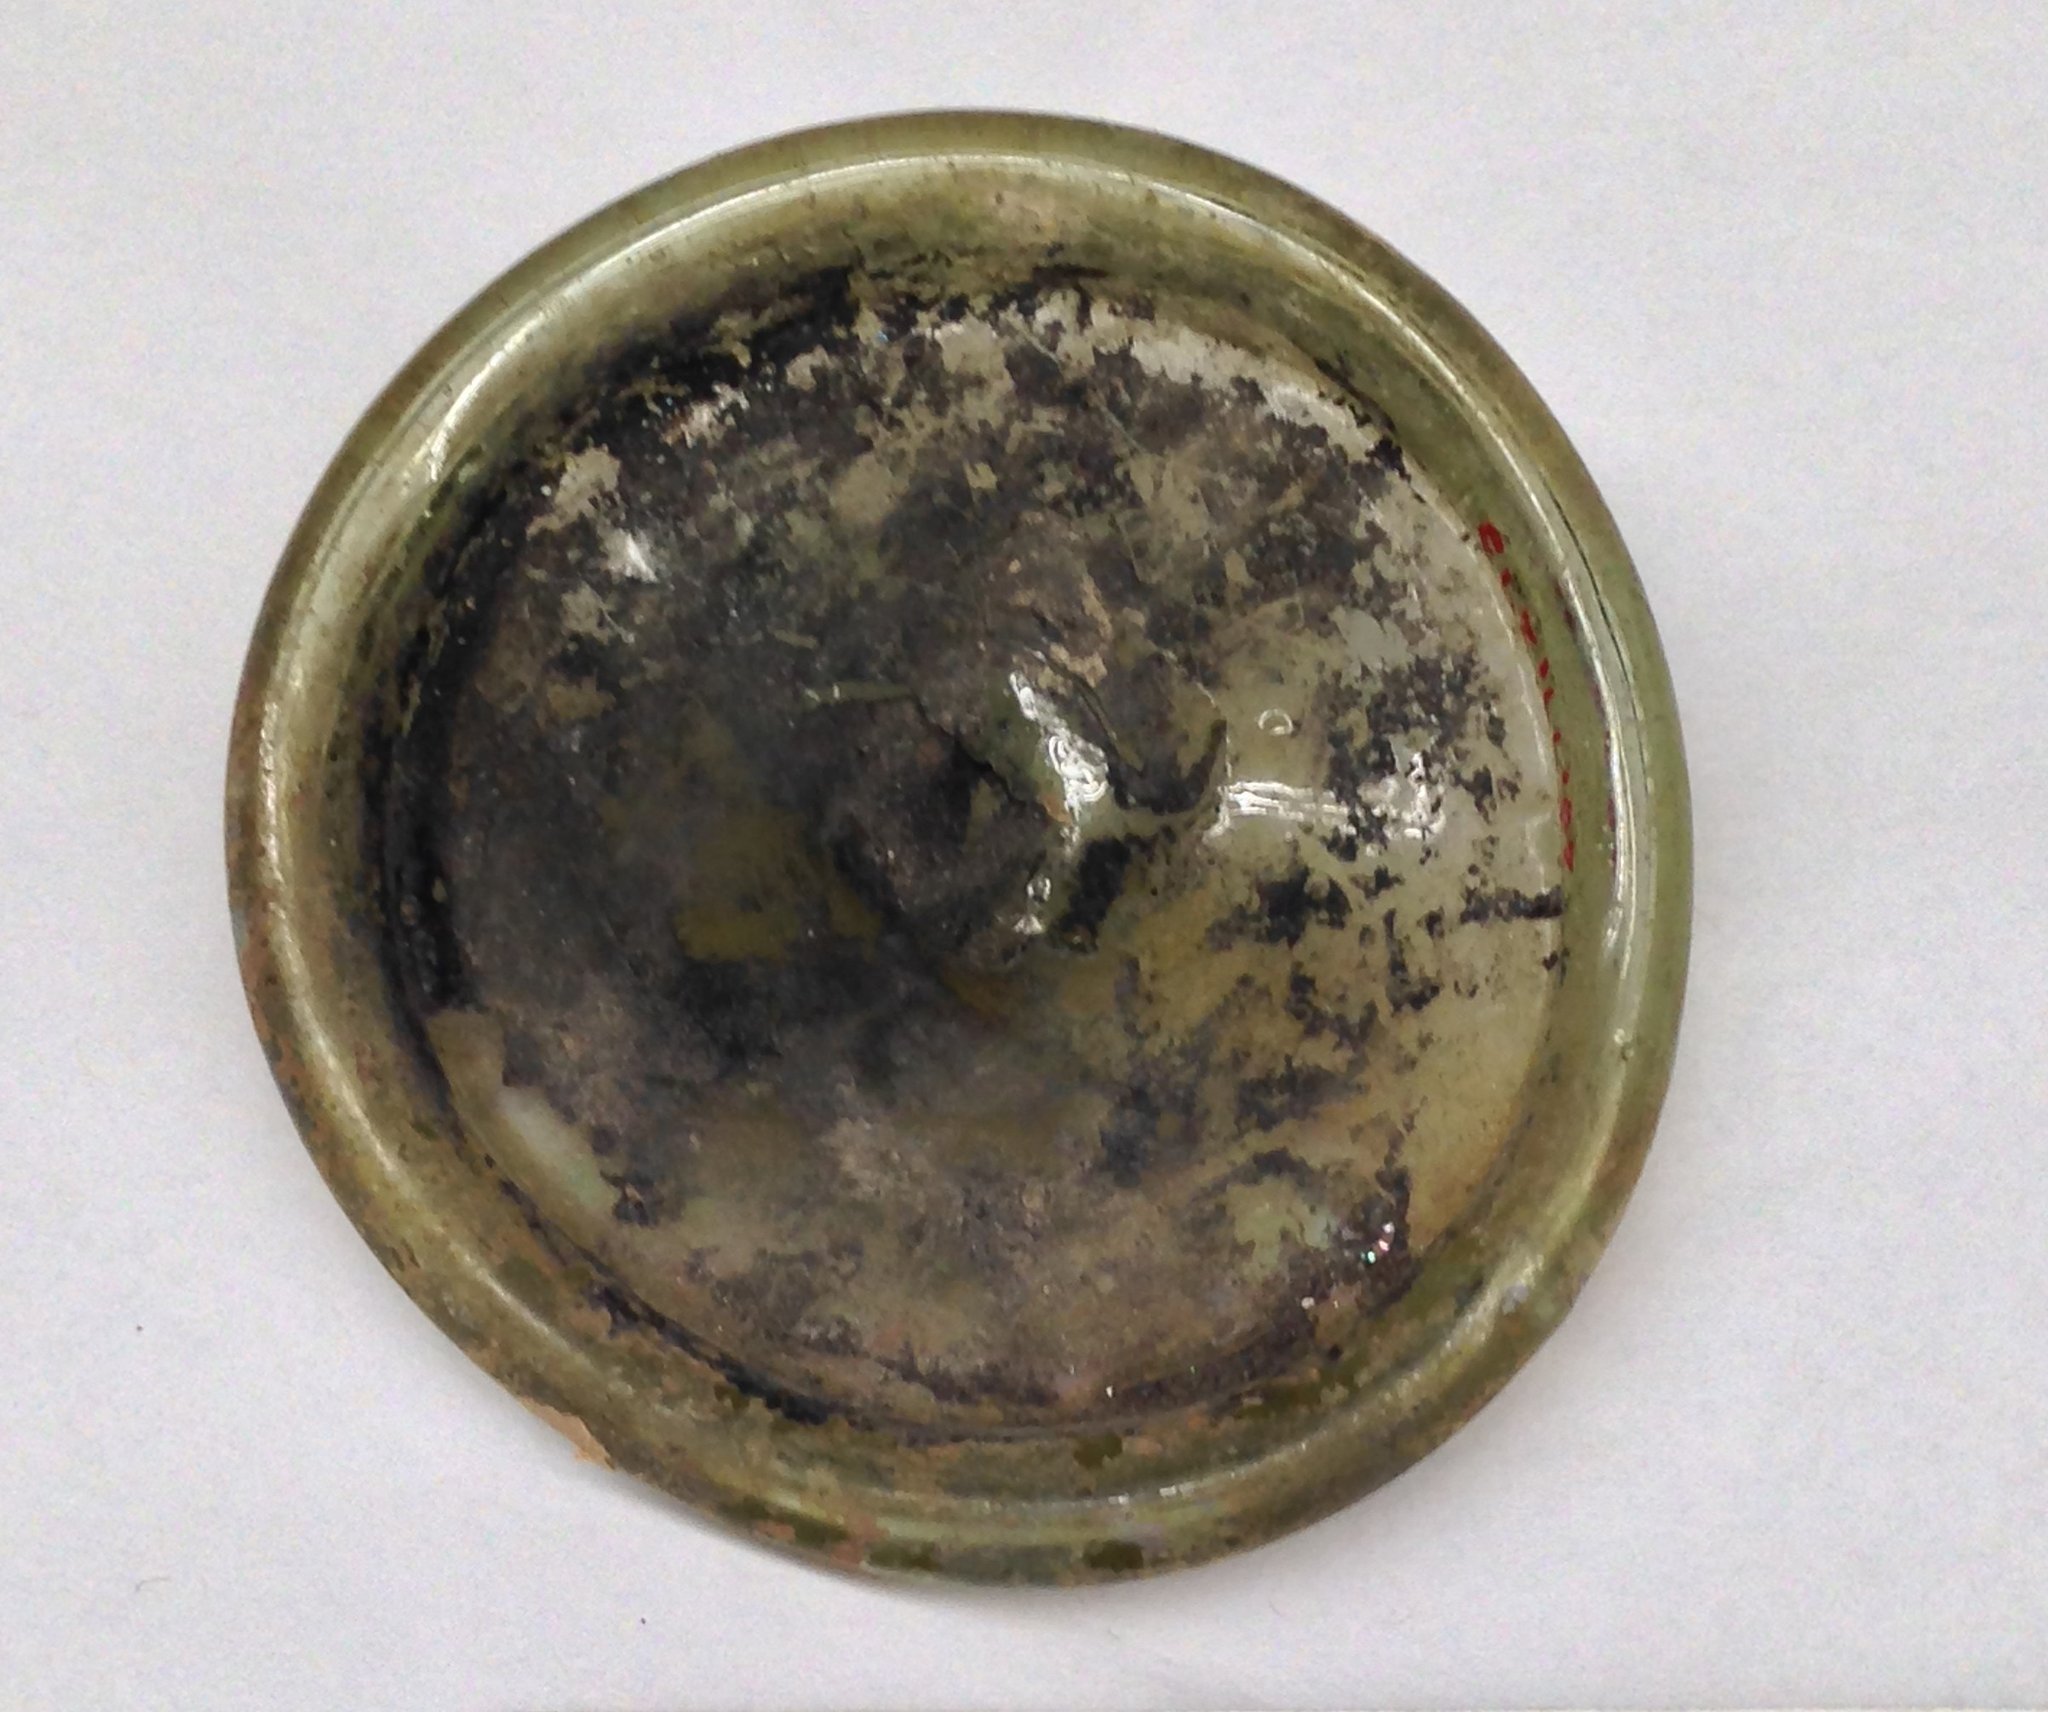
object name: fragment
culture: european or middle eastern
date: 1150-1250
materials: ceramic, glass